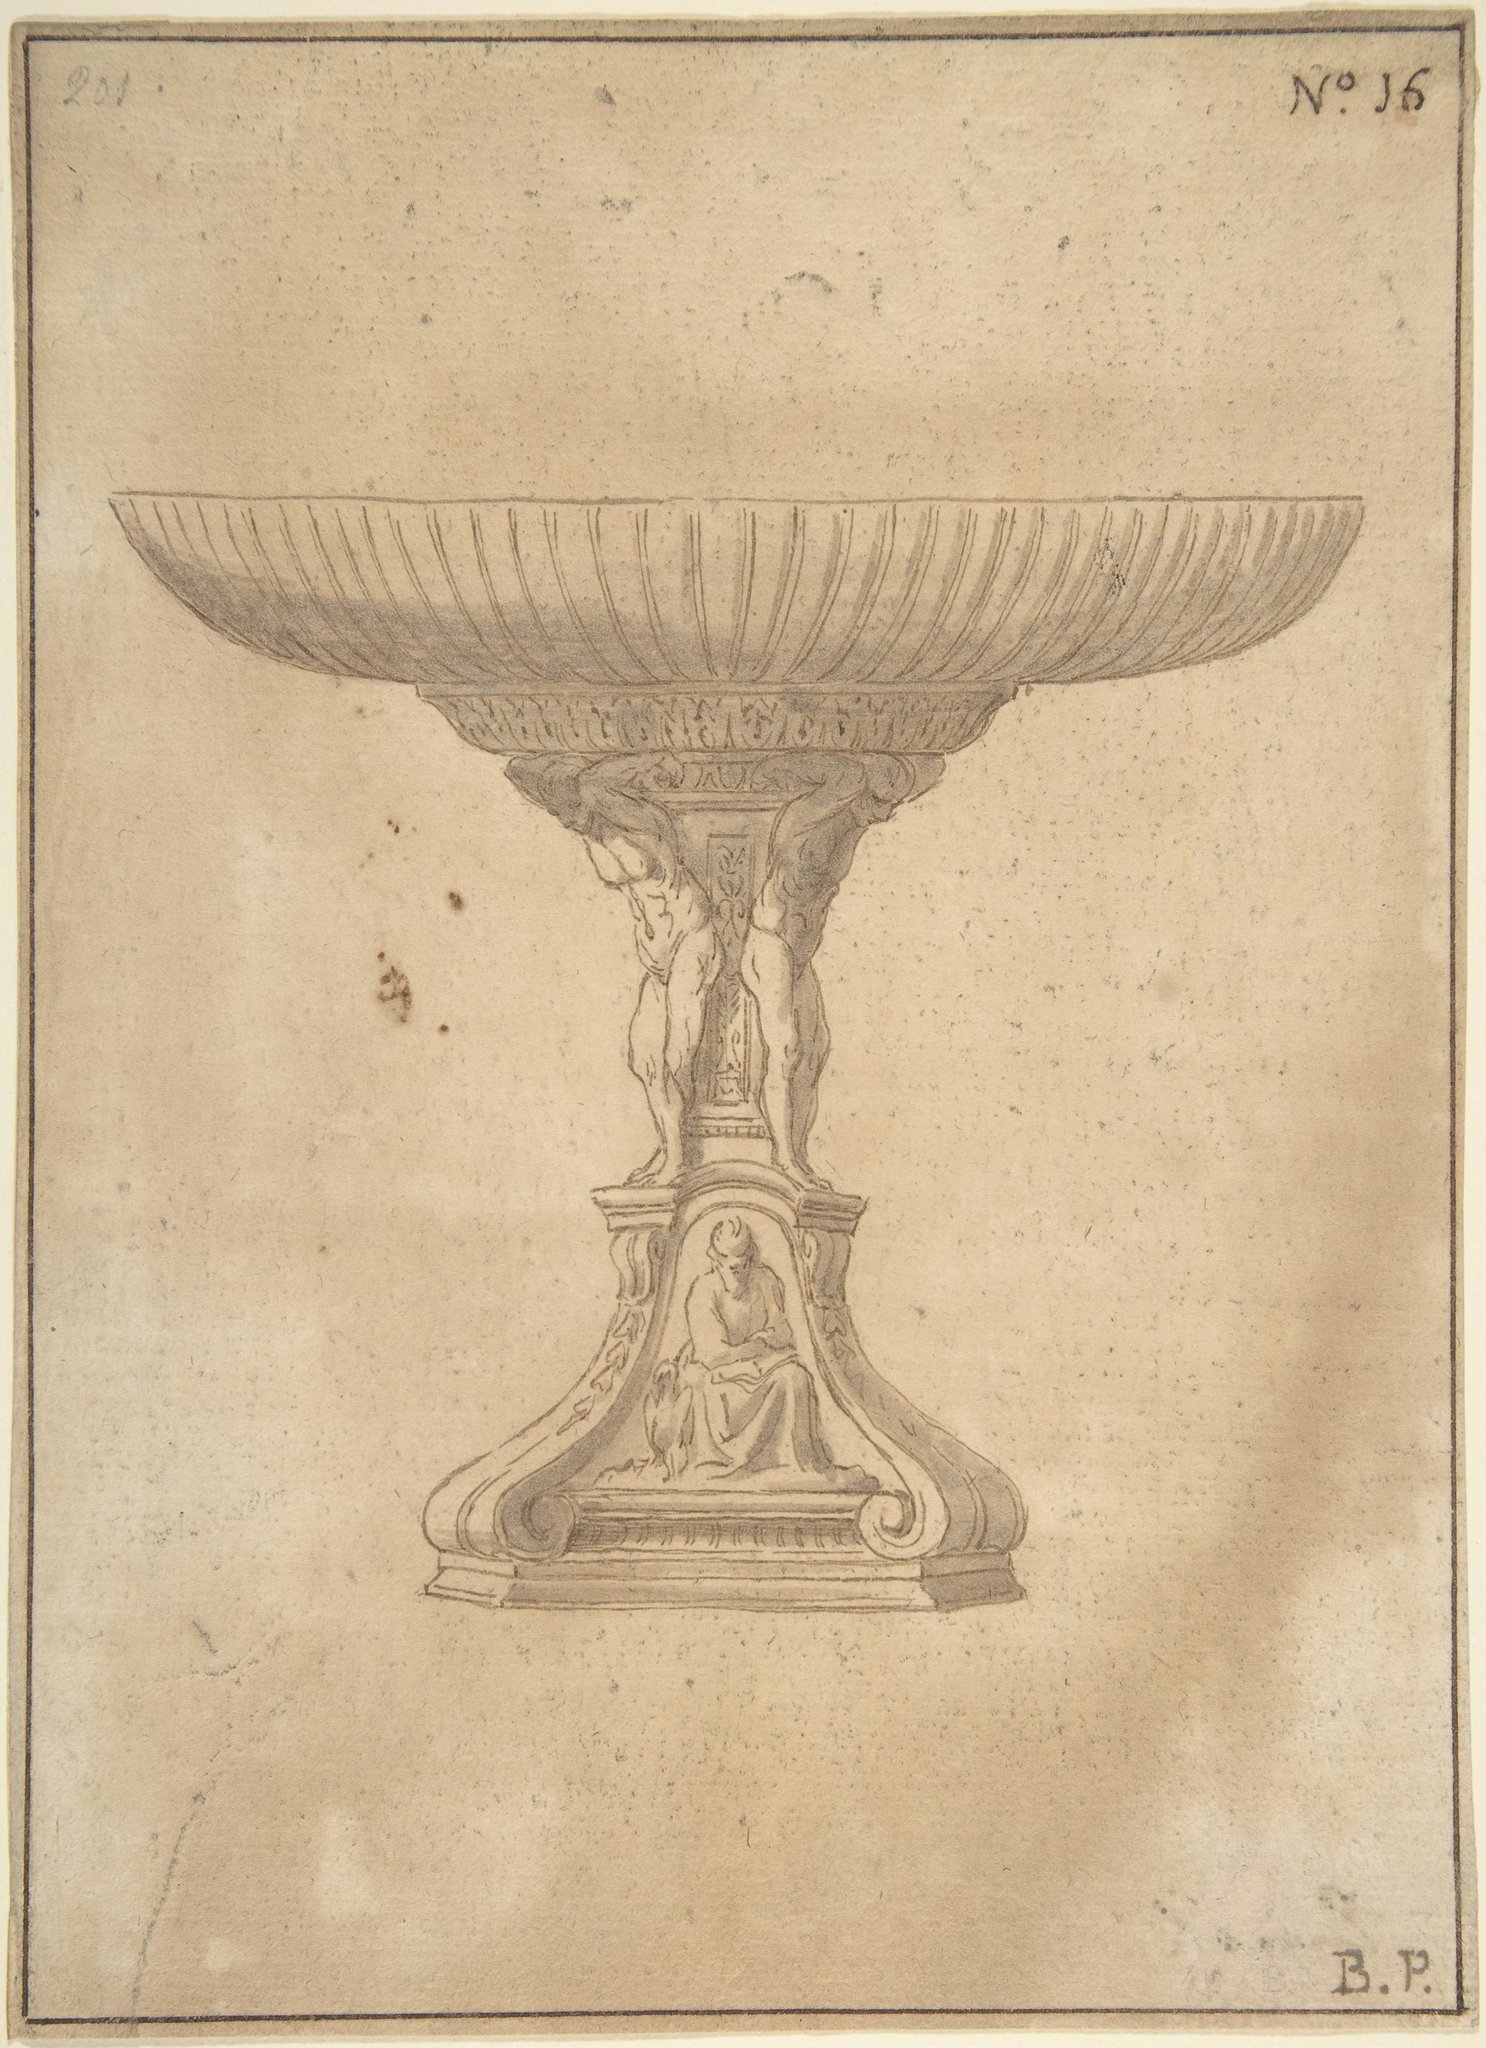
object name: drawing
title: Design for a Cup Supported by Standing Nudes with Standard of Seated Figure with Book and Bird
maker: jacopo da empoli (jacopo chimenti)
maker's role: artist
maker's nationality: italian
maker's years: 1551-1640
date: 1501-1600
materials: ink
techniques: brush, pen, wash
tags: men,male nudes,cups